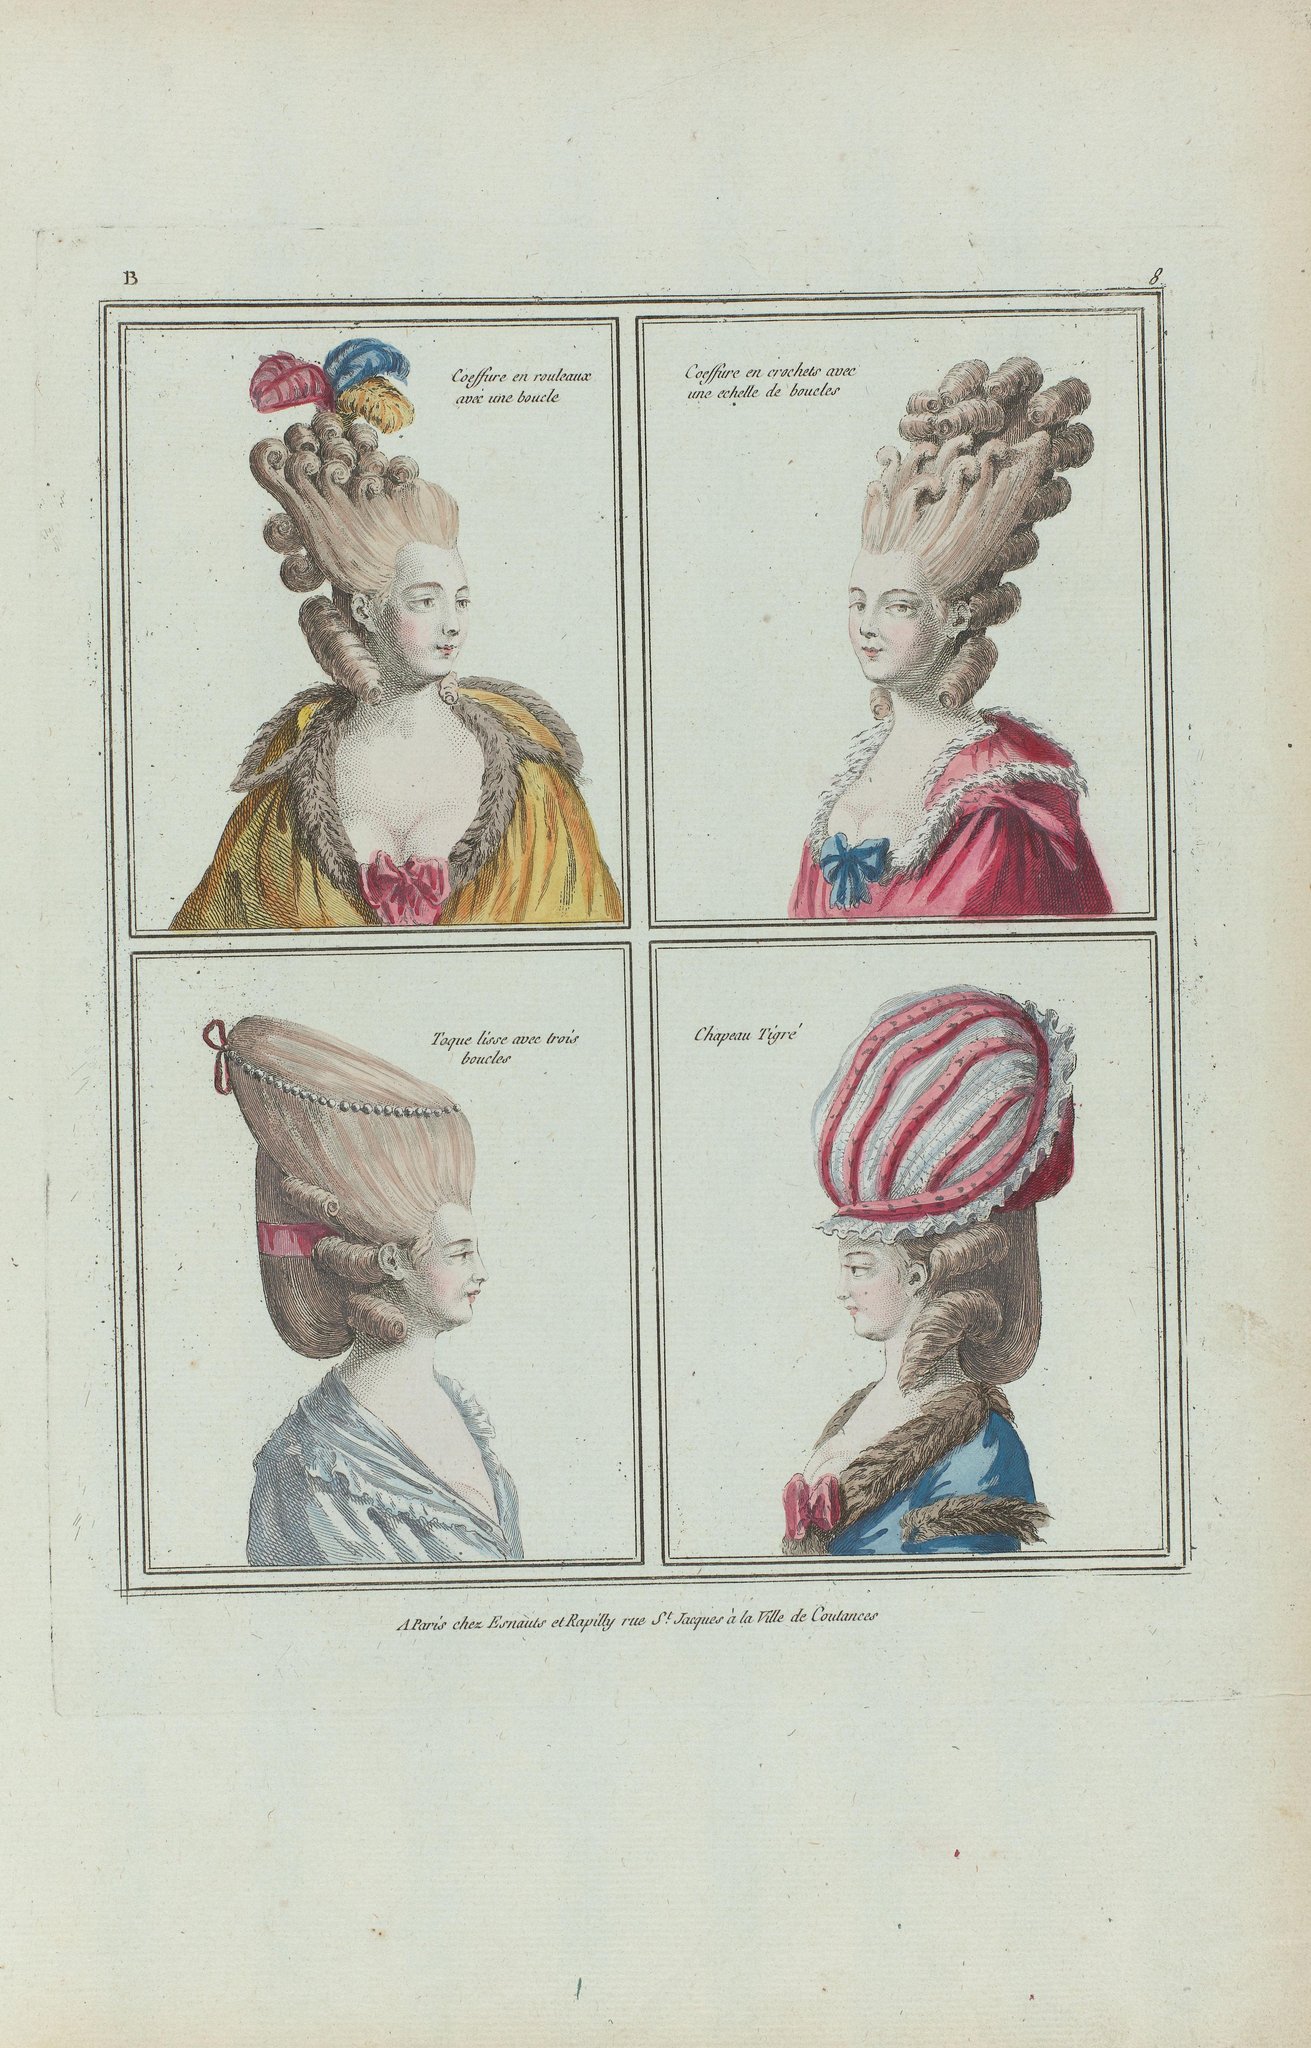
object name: fashion print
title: Gallerie des Modes et Costumes Francais, depuis 1776, B 8 : Coeffure en rouleaux (...)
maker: Anonymous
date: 1776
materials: paper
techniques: engraving, hand coloring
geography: paris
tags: clothing for the upper part of the body (+ women's clothes), styles of hairdress - aa - ~ women, fashion plates, head-gear: hat (+ women's clothes)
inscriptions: inscription: ‘Coeffure en rouleaux avec une boucle / Coeffure en crochets avec une echelle de boucles / Toque lisse avec trois boucles / Chapeau Tigré’, address: ‘A Paris chez Esnauts et Rapilly rue St. Jacques à la Ville de Coutances’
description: Vier vrouwenkapsels, waarvan één met hoed, verdeeld in kaders. Van linksboven naar rechtsonder: Coeffure en rouleaux avec une boucle, Coeffure en crochets avec une echelle de boucles, Toque lisse avec trois boucles, Chapeau Tigré'. Prent uit serie B. 2e Cahier des Nouveaux Costumes Français pour les coeffures, Gallerie des Modes et Costumes Français.